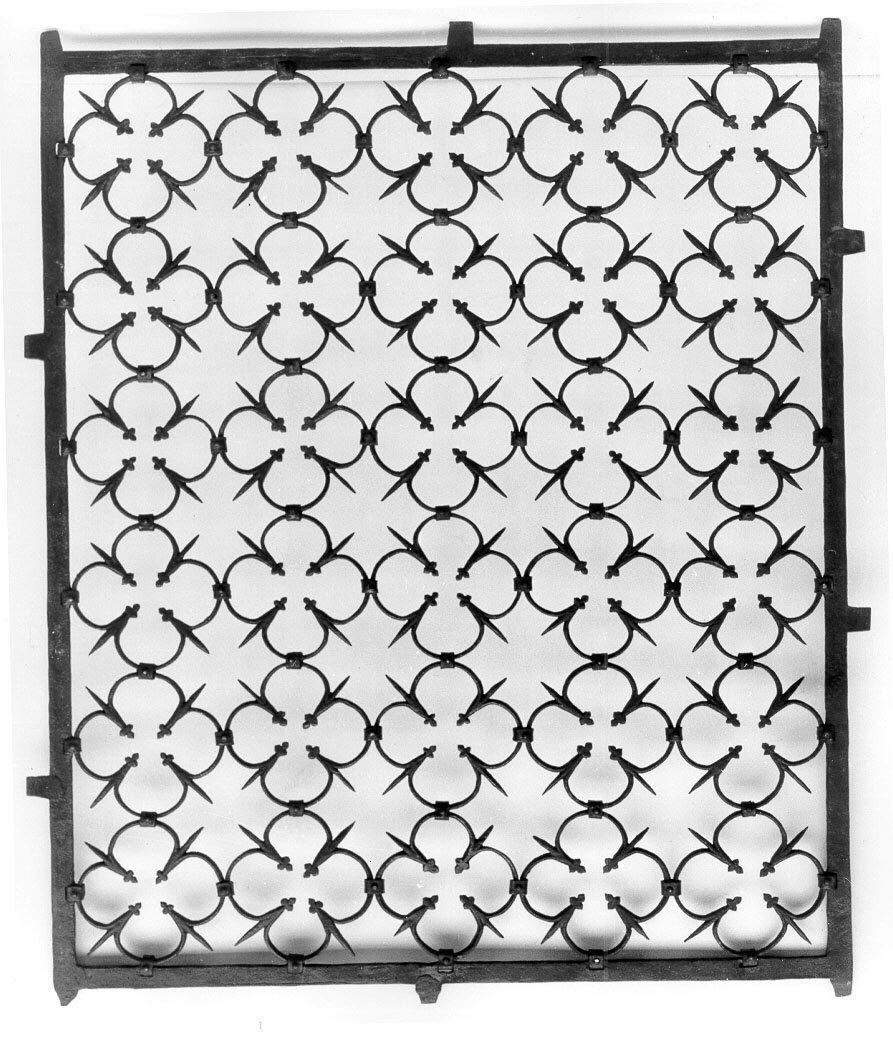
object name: grill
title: Grille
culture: european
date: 1401-1600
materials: iron